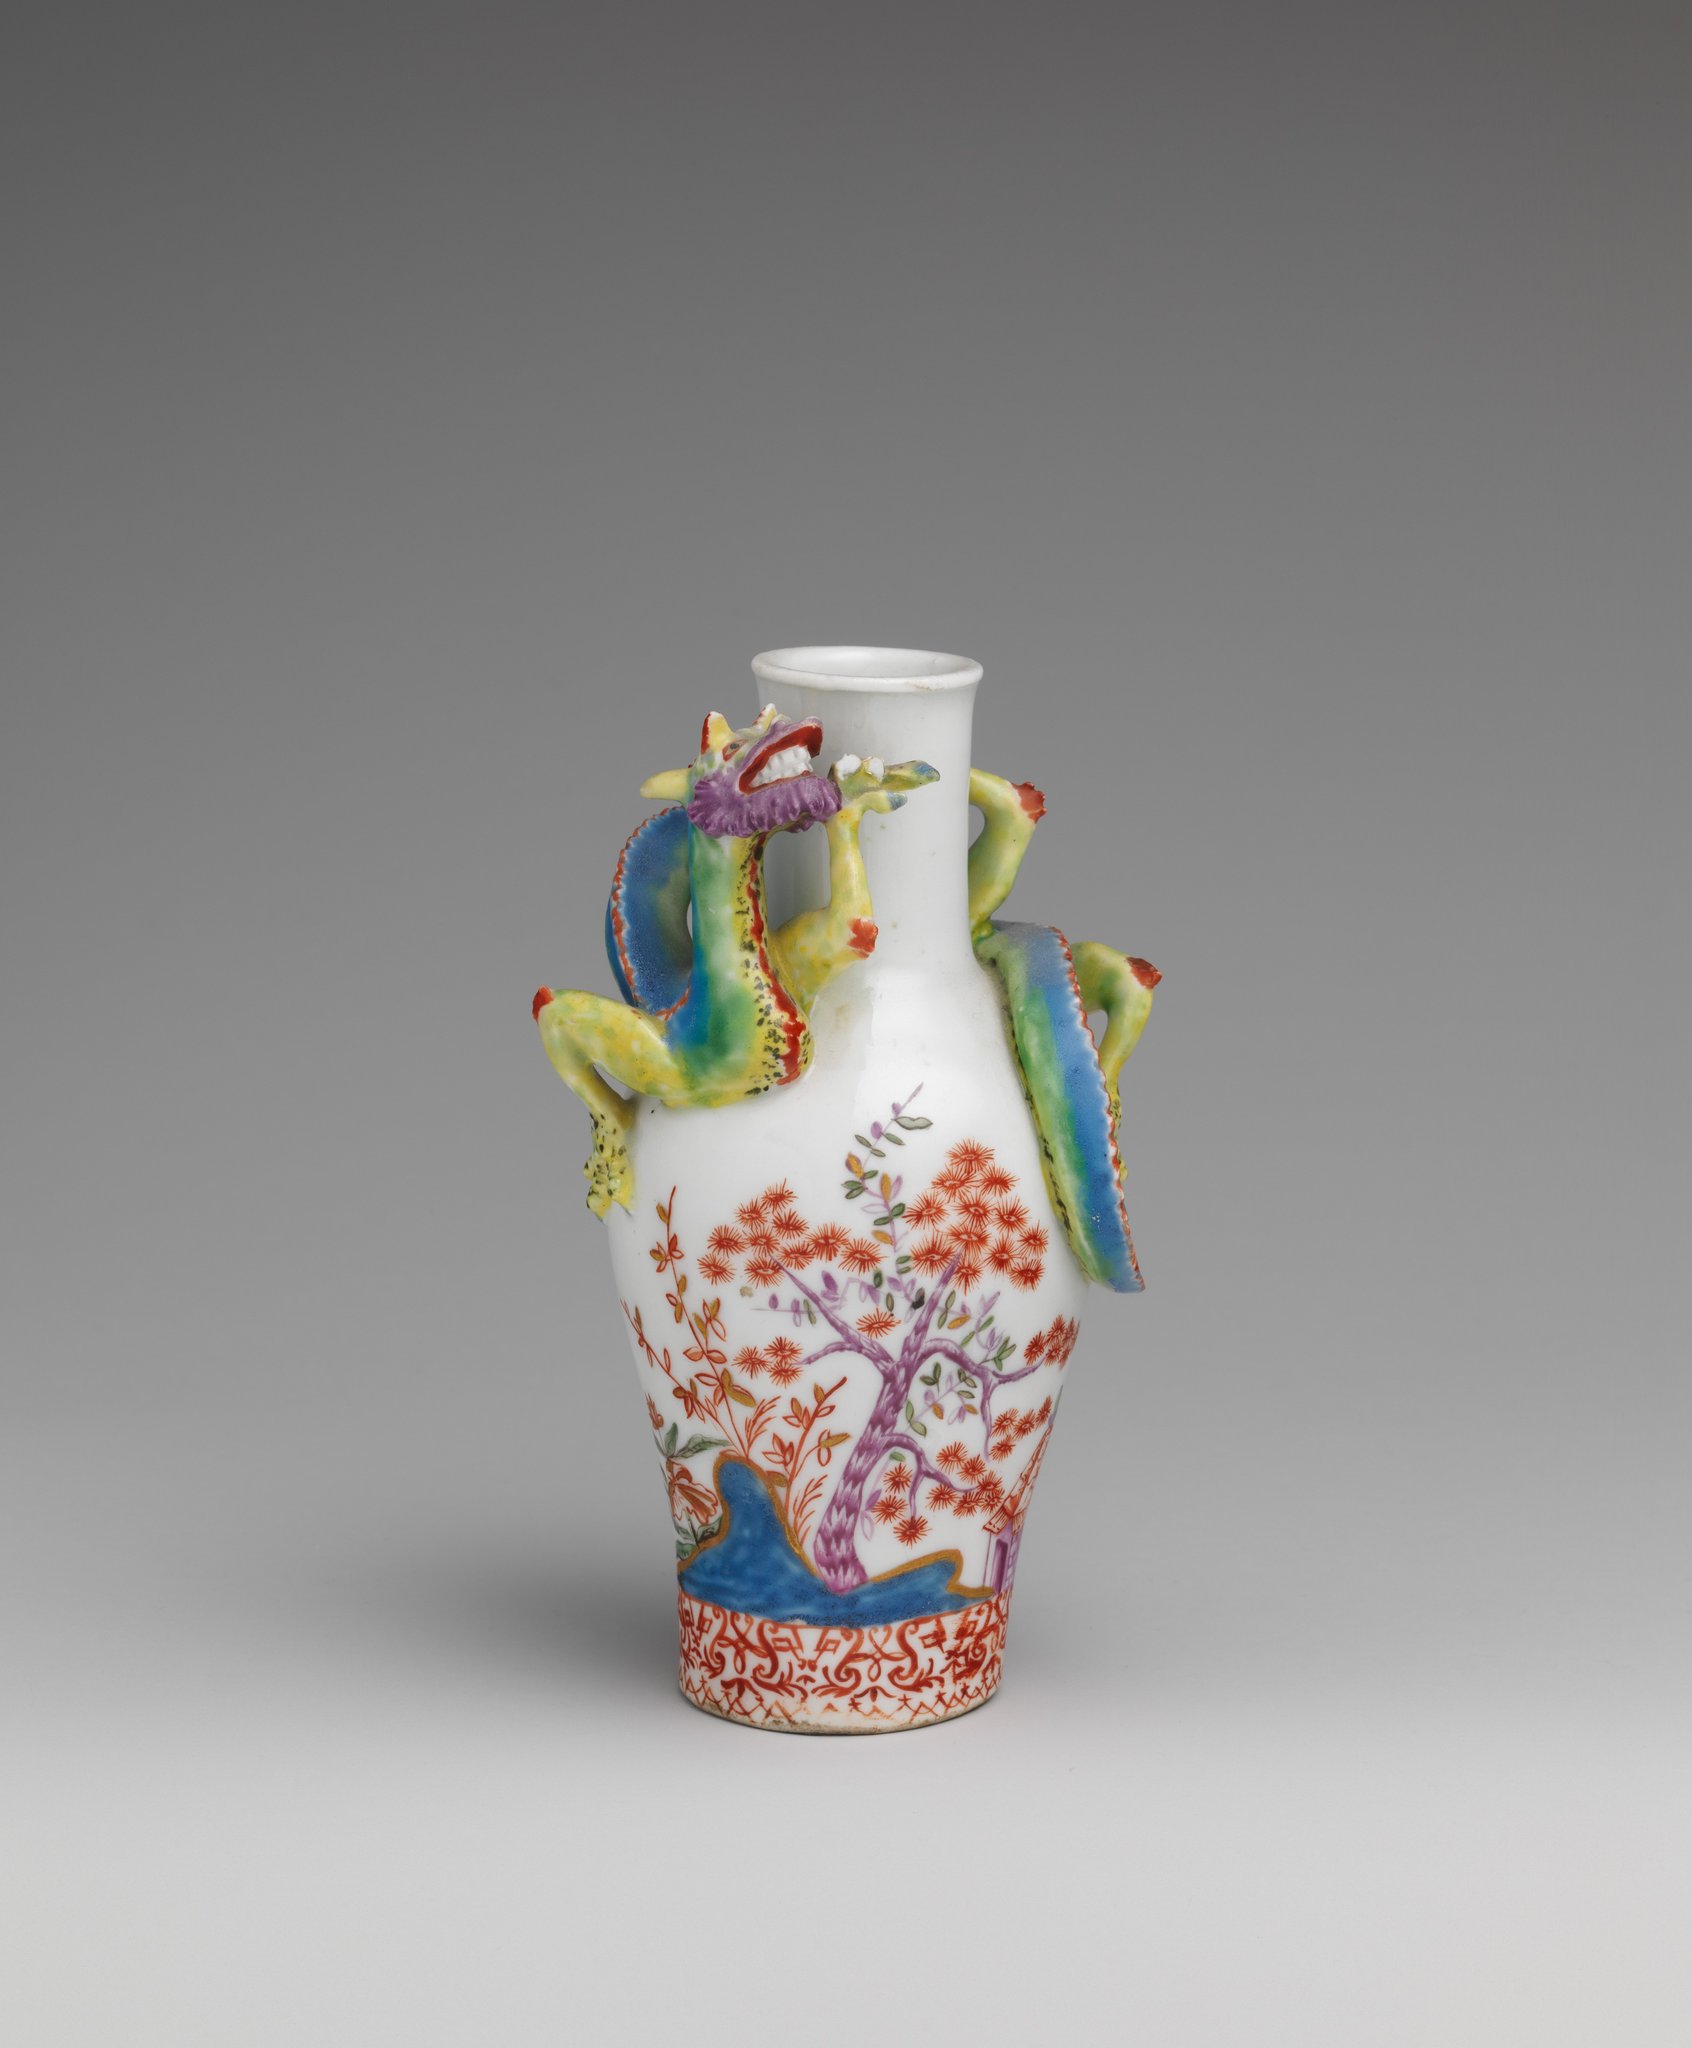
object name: vase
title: Vase (one of a pair)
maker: vienna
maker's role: manufactory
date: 1730-1740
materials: hard paste porcelain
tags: dragons,trees